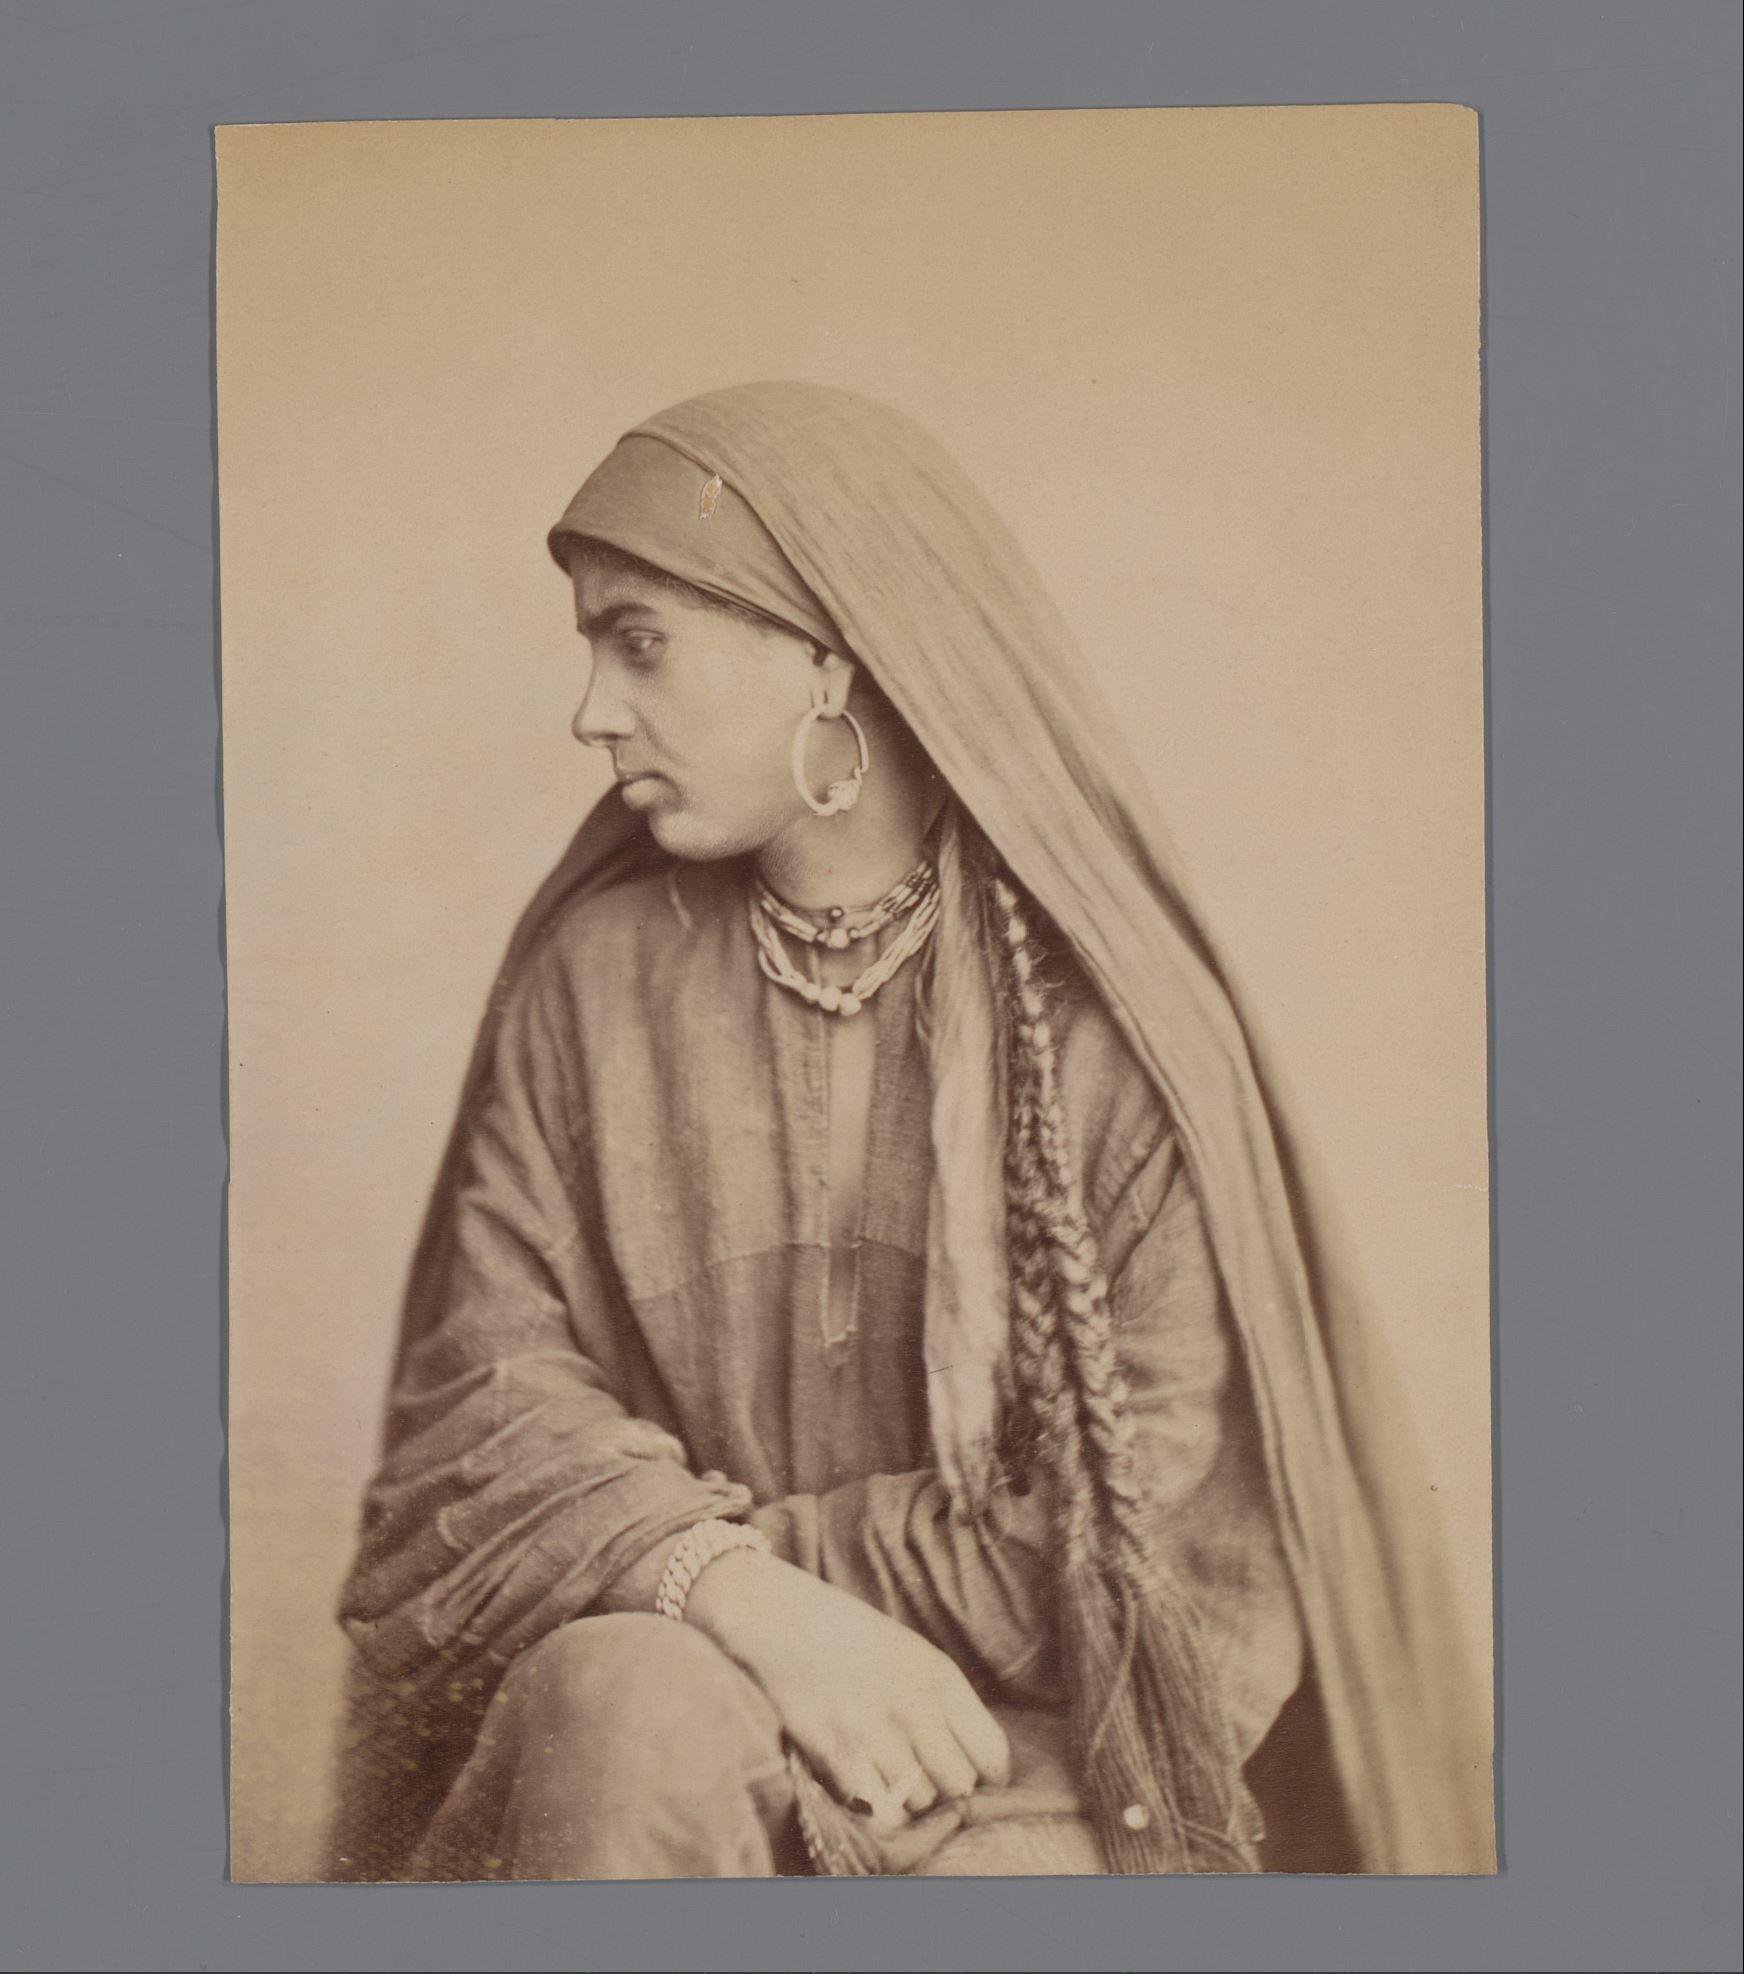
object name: photograph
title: Vrouw in profiel in inheemse kleding met lange vlechten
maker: Anonymous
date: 1880-1900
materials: paper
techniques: albumen print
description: Vrouw in profiel in inheemse kleding met lange vlechten.